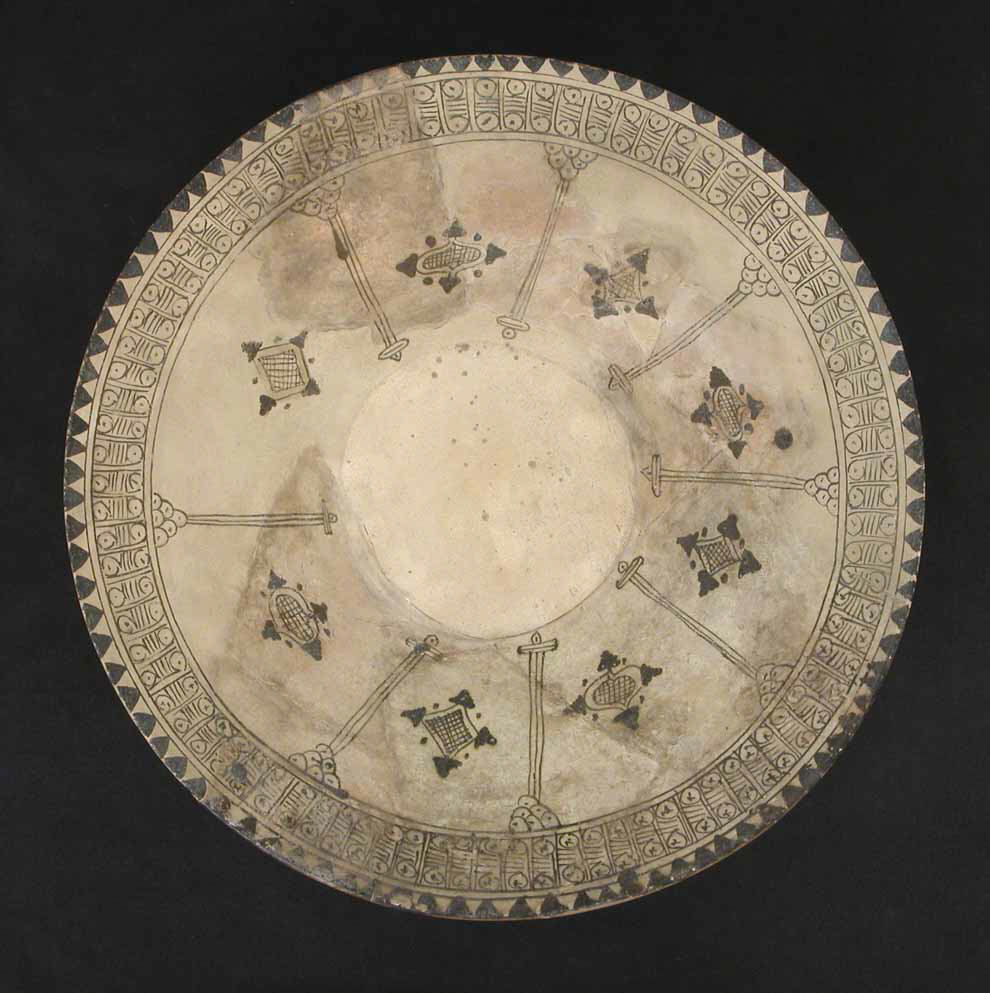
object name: bowl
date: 801-1000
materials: earthenware, glaze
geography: iran